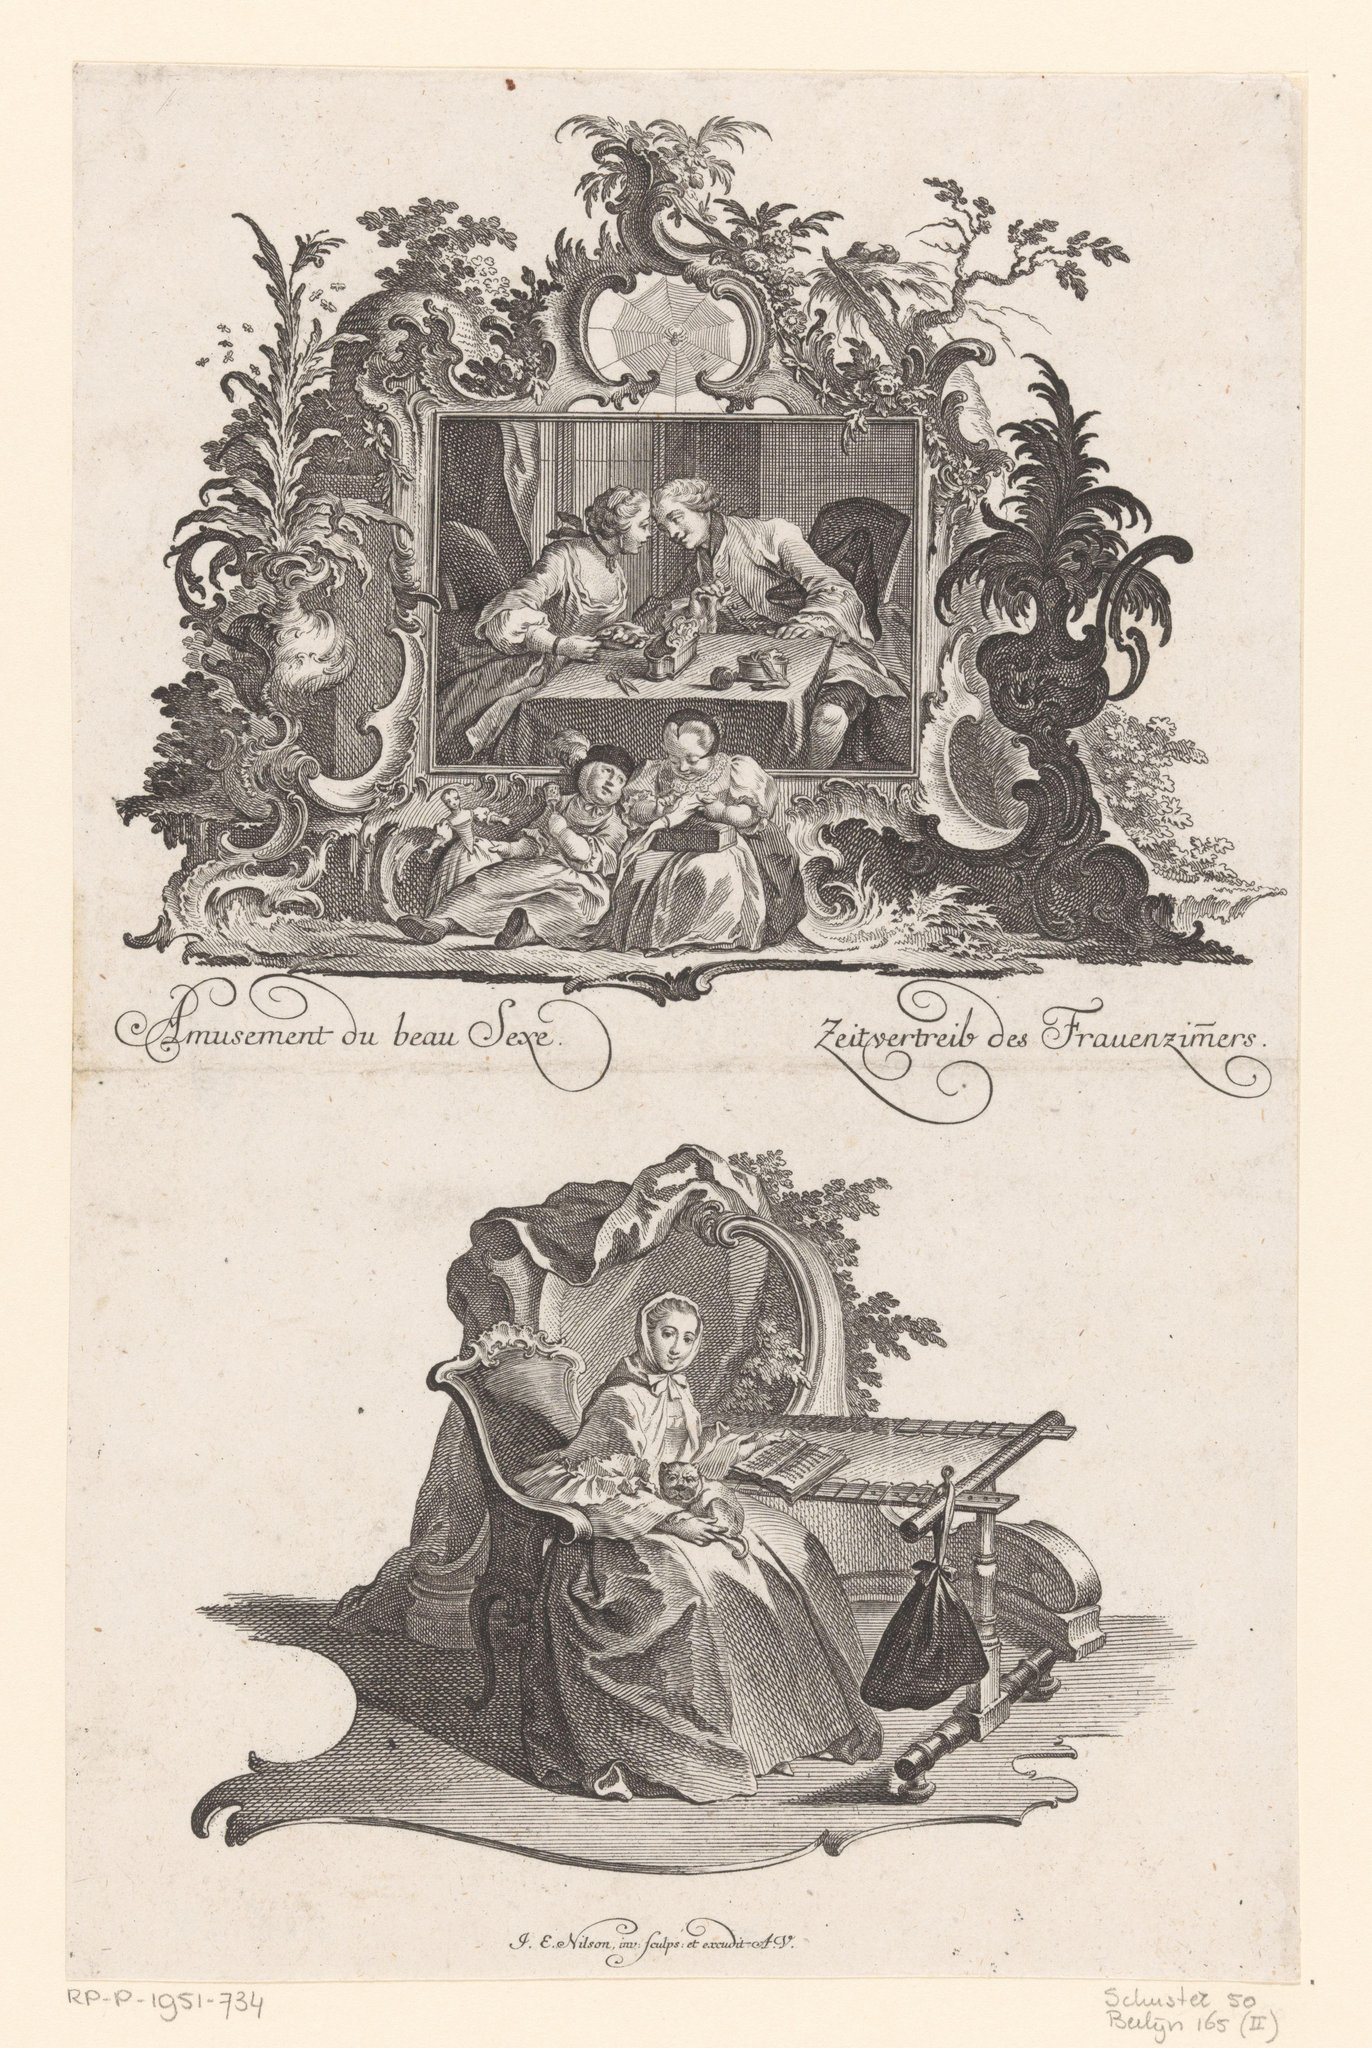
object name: ornament print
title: Amusement du beau Sexe / Zeitvertreib des Frauenzimers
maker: johann esaias nilson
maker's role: draughtsman, print maker, publisher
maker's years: 1721-1788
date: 1731-1788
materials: paper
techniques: engraving, etching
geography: augsburg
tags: embroidering ~ textile industry, (lovers) kissing each other, sewing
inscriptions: collector's mark: Lugt 2228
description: Twee scènes op een blad. Boven: Een man en vrouw aan tafel staan op het punt elkaar te kussen. Op de tafel ligt naaigerei. De voorstelling bevindt zich in een rechthoekige lijst omgeven door rocaille ornamenten, een bijenkorf, een vogelnest en twee meisjes. Onder: Een vrouw zit met een hond op schoot en een boek in haar hand voor een weefgetouw.